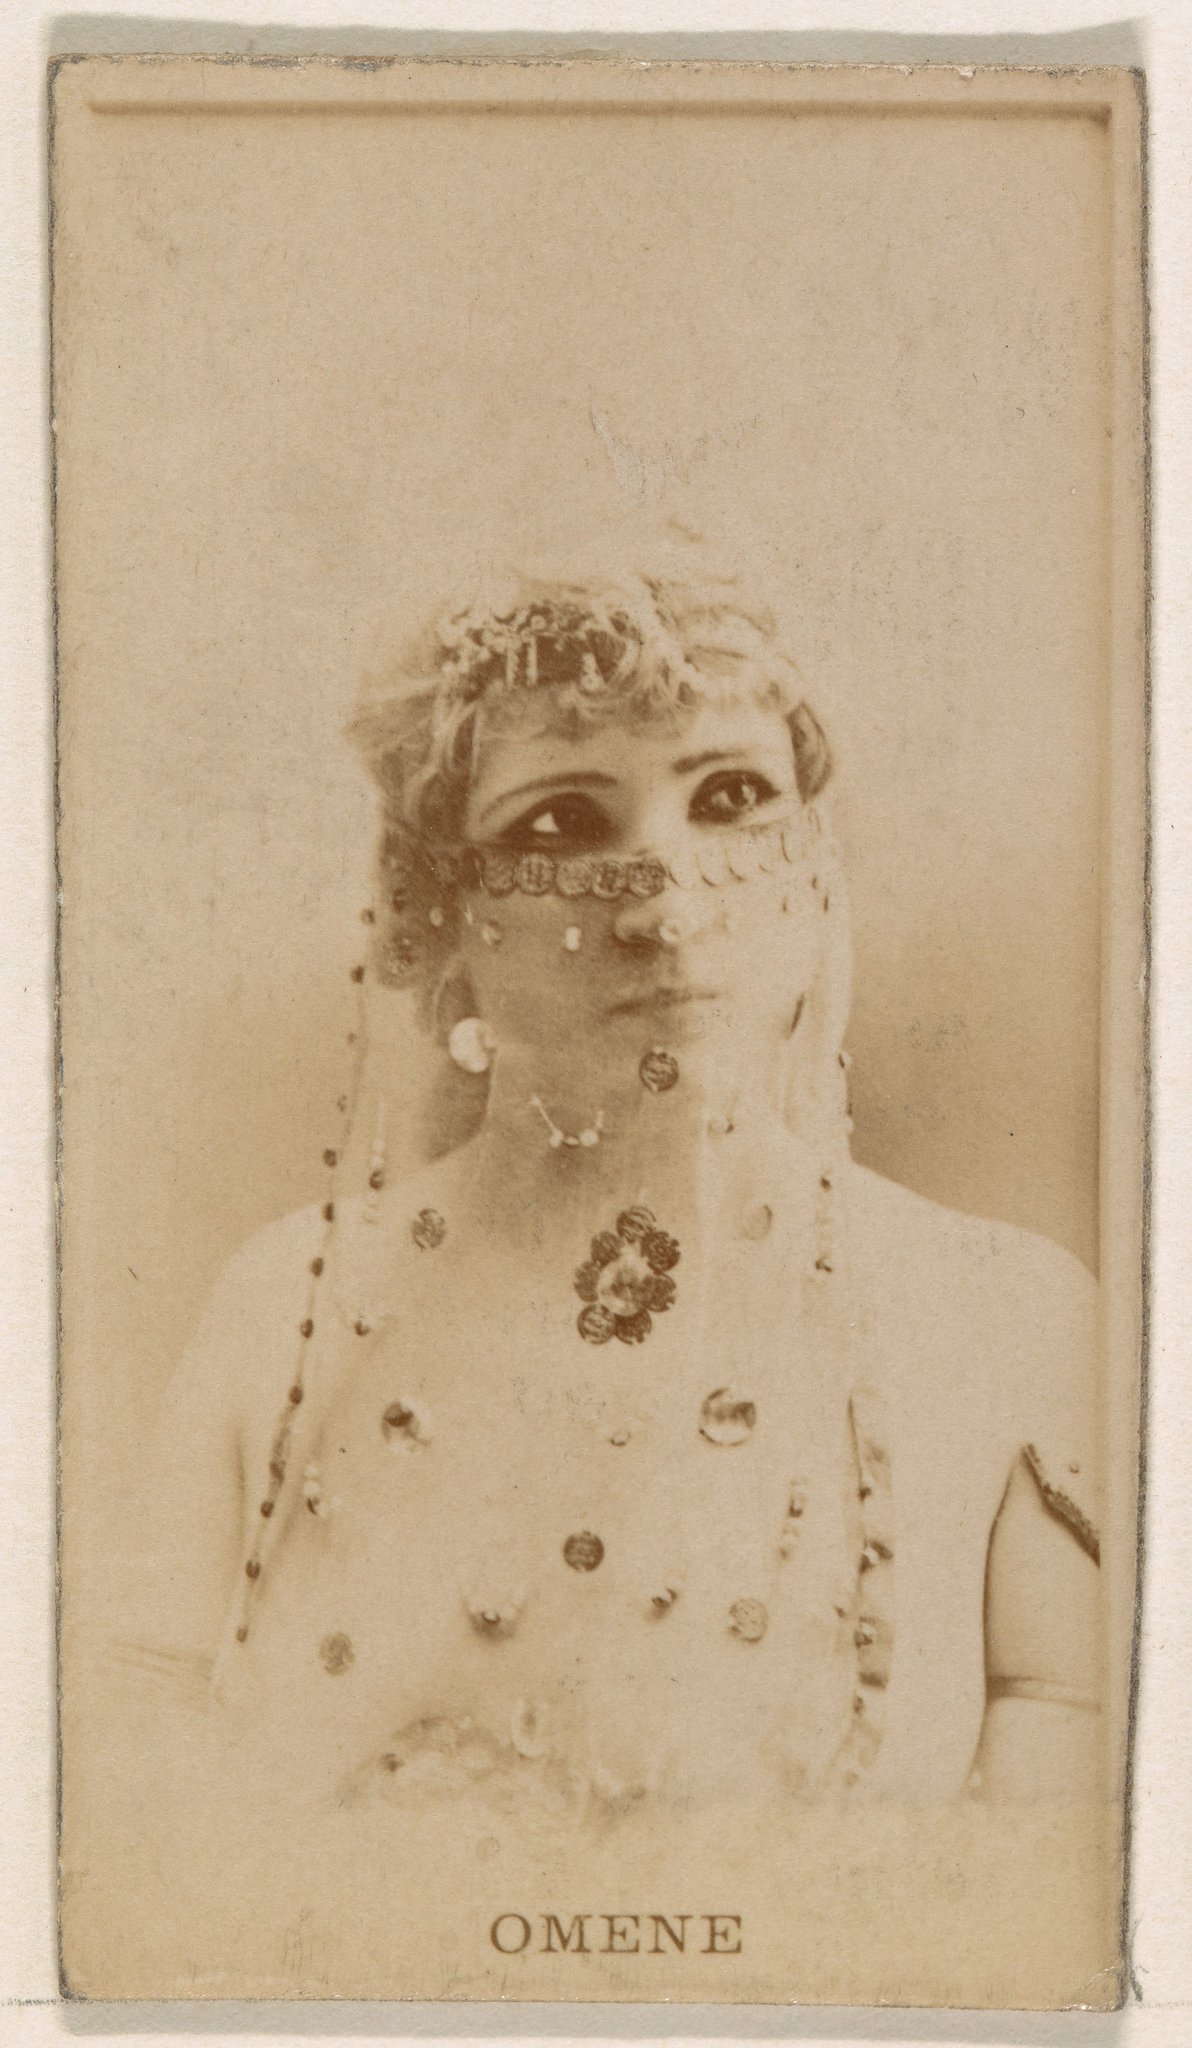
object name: photograph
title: Omene, from the Actresses series (N245) issued by Kinney Brothers to promote Sweet Caporal Cigarettes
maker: kinney brothers tobacco company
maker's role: publisher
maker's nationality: american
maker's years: 1869-2011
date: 1890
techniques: albumen silver print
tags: portraits,women,actresses